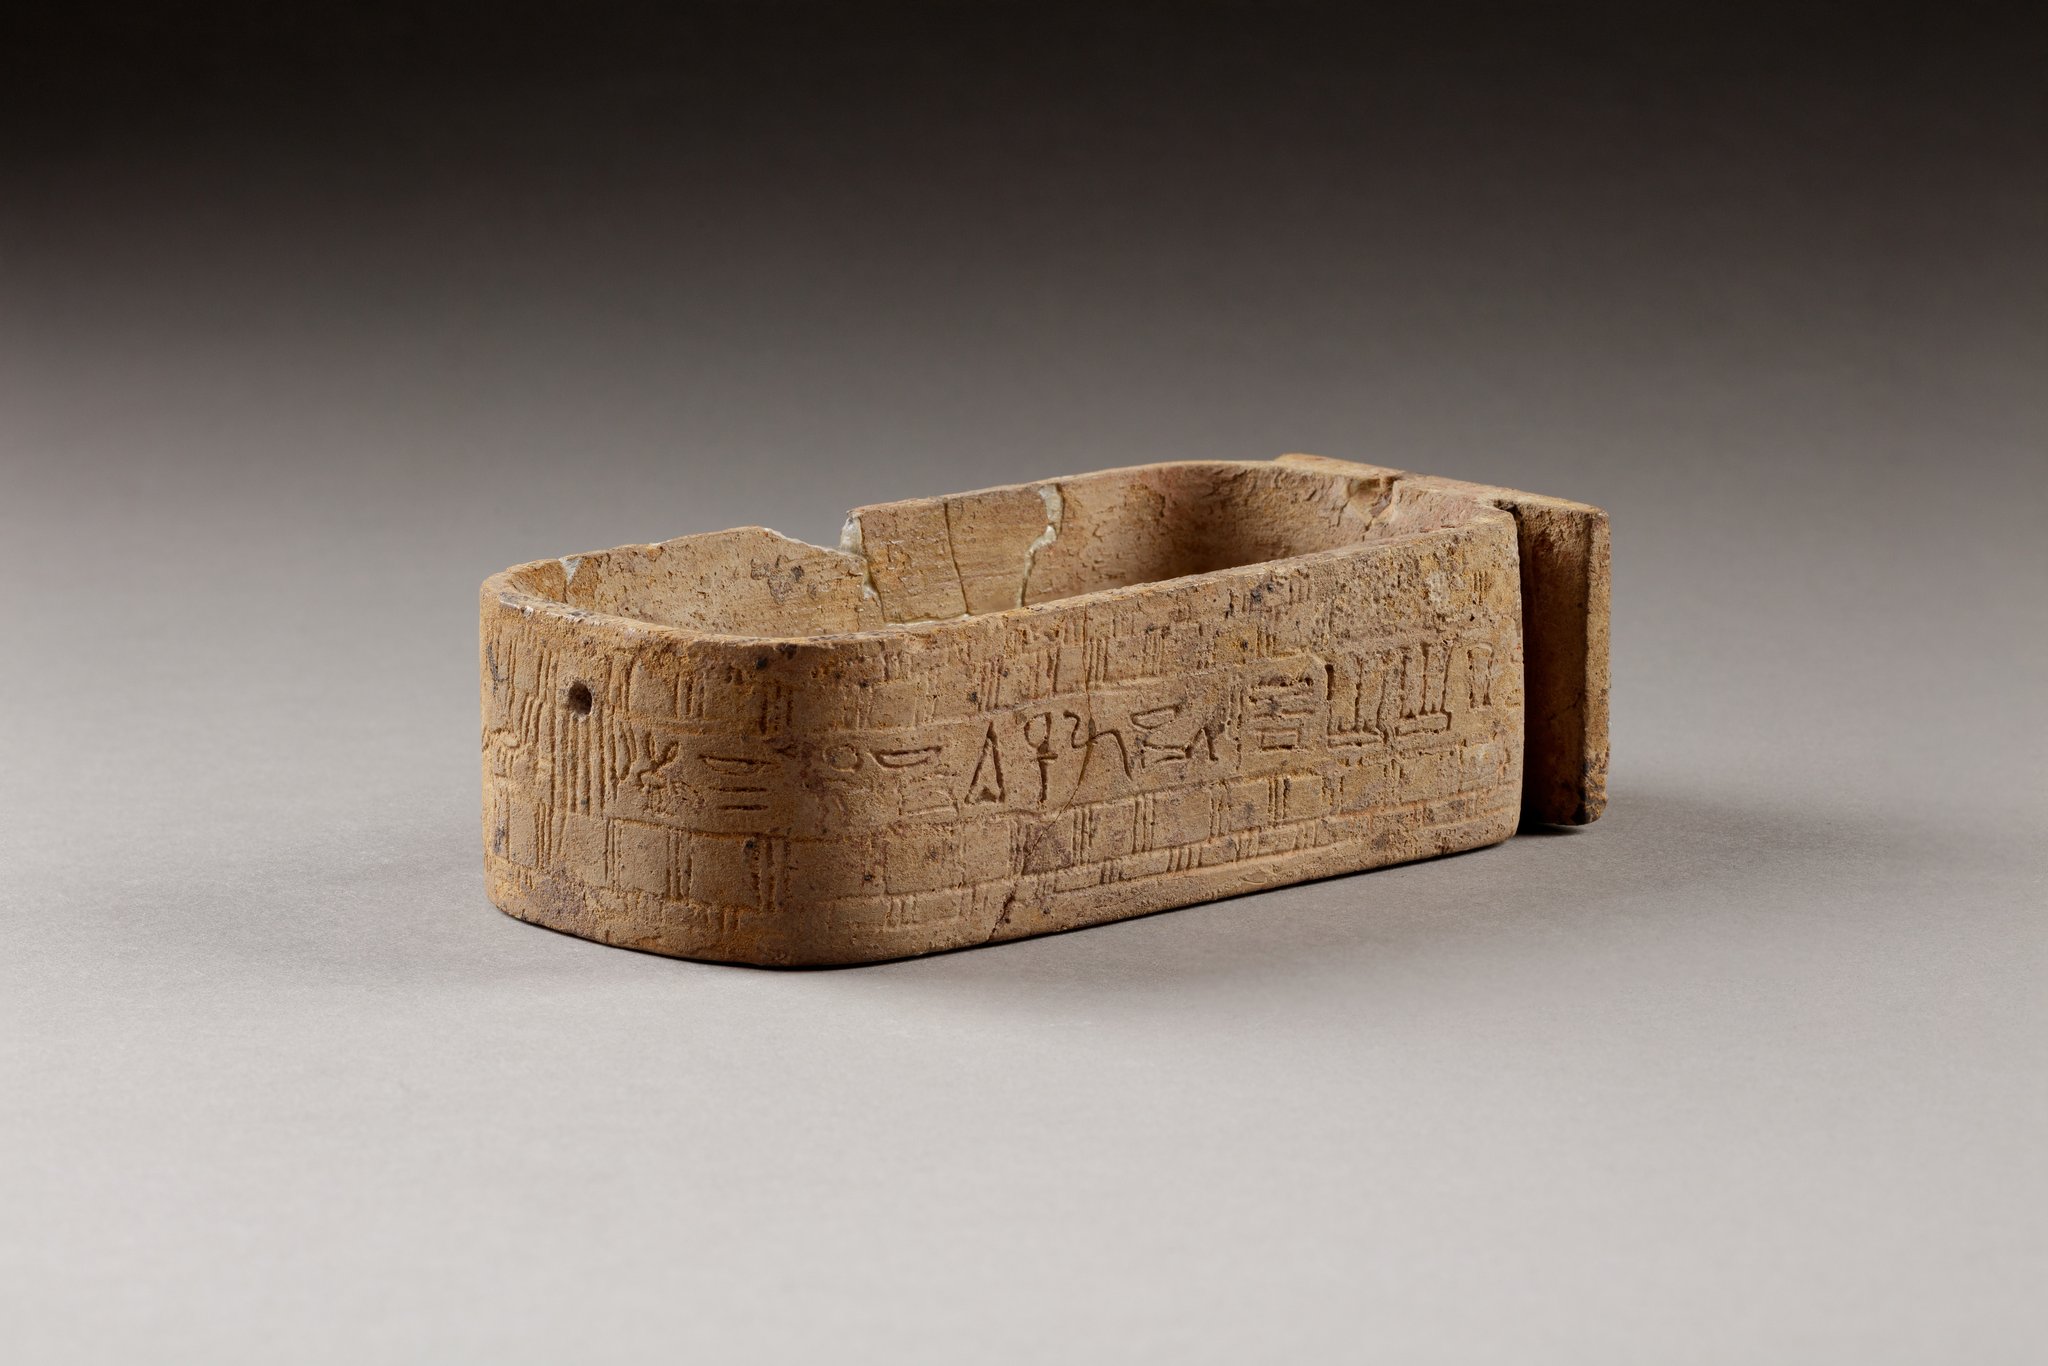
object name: box, usermaatre sheshonq sibast, sheshonq iii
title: Cartouche shaped box inscribed for Usermaatre Sheshonq-Sibast, Sheshonq III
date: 825-773 BCE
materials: stone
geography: egypt